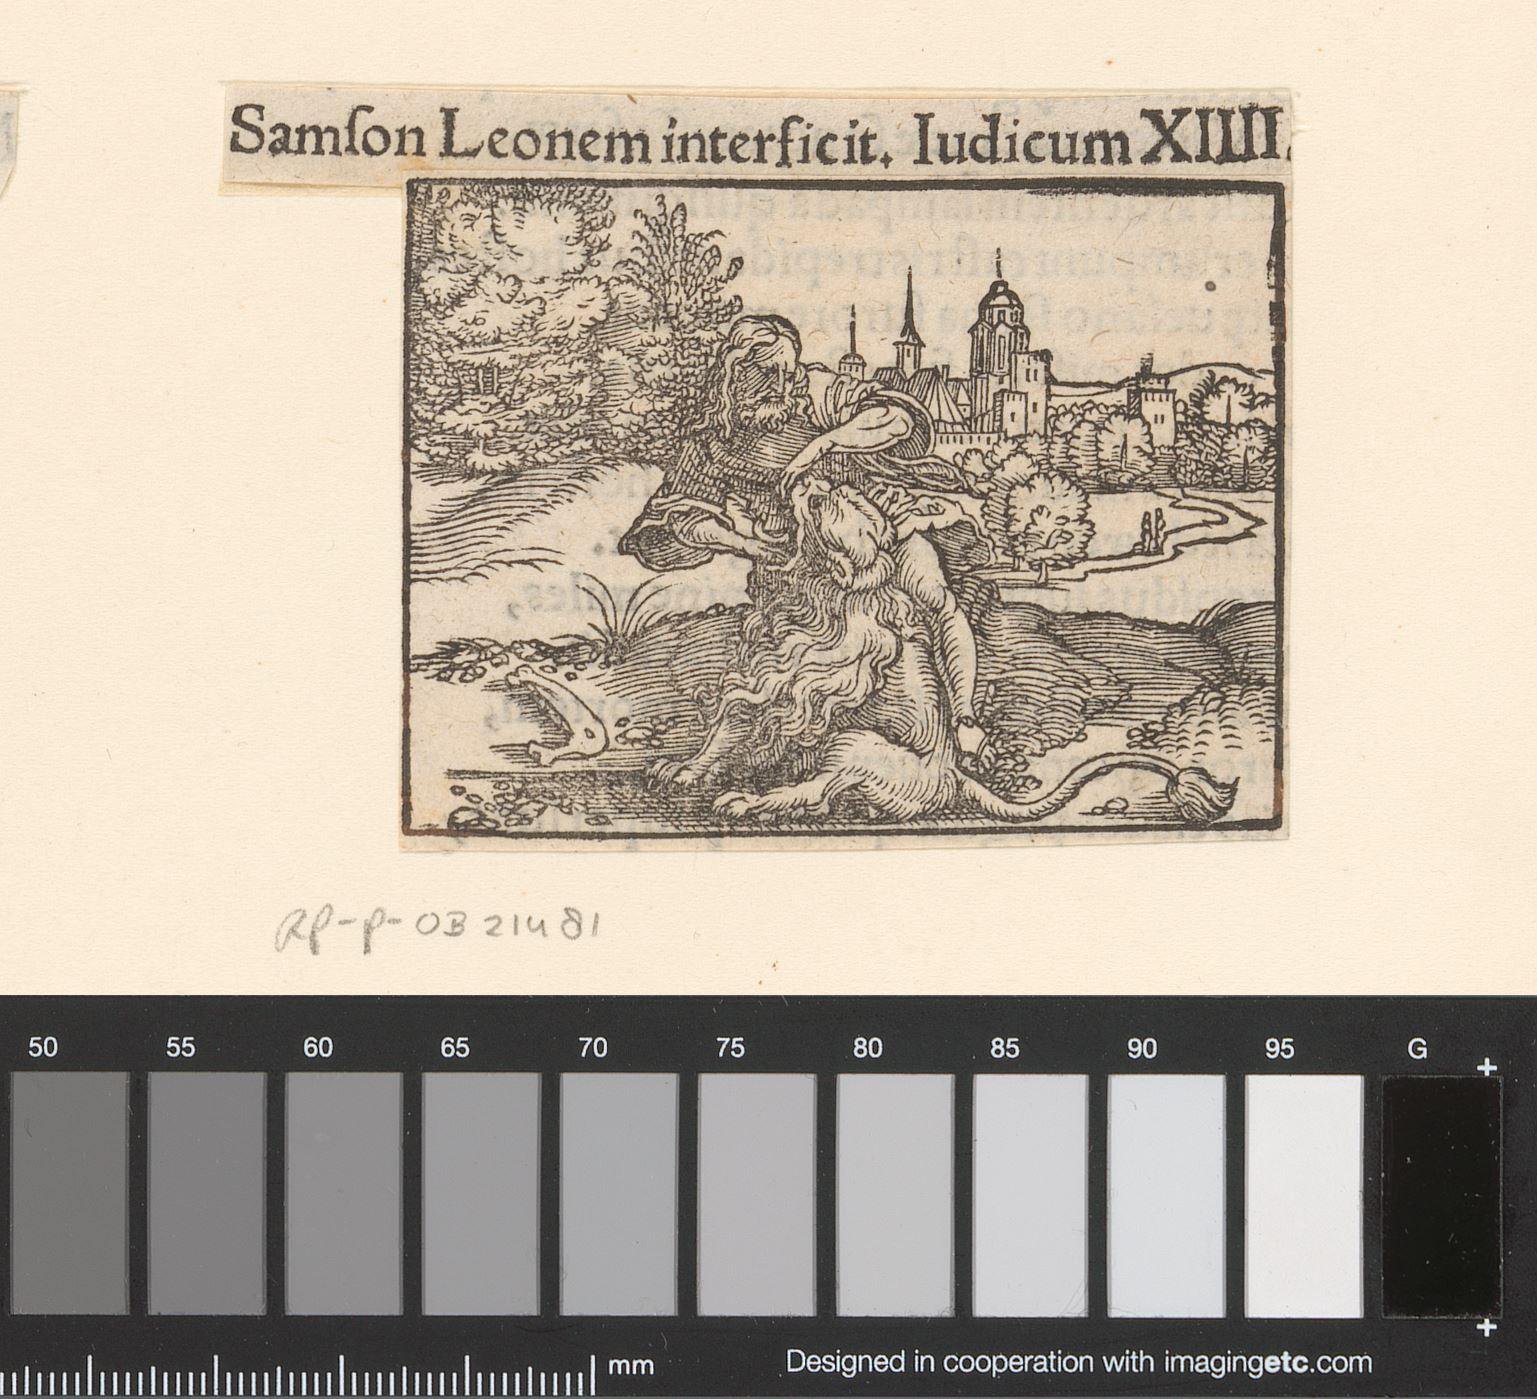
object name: book illustration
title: Samson Leonem interficit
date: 1530-1533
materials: paper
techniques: woodcut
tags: samson kills the lion with his bare hands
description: Prent afkomstig uit: Biblicae historiae. Frankfurt am Main: Egenloph, 1539.